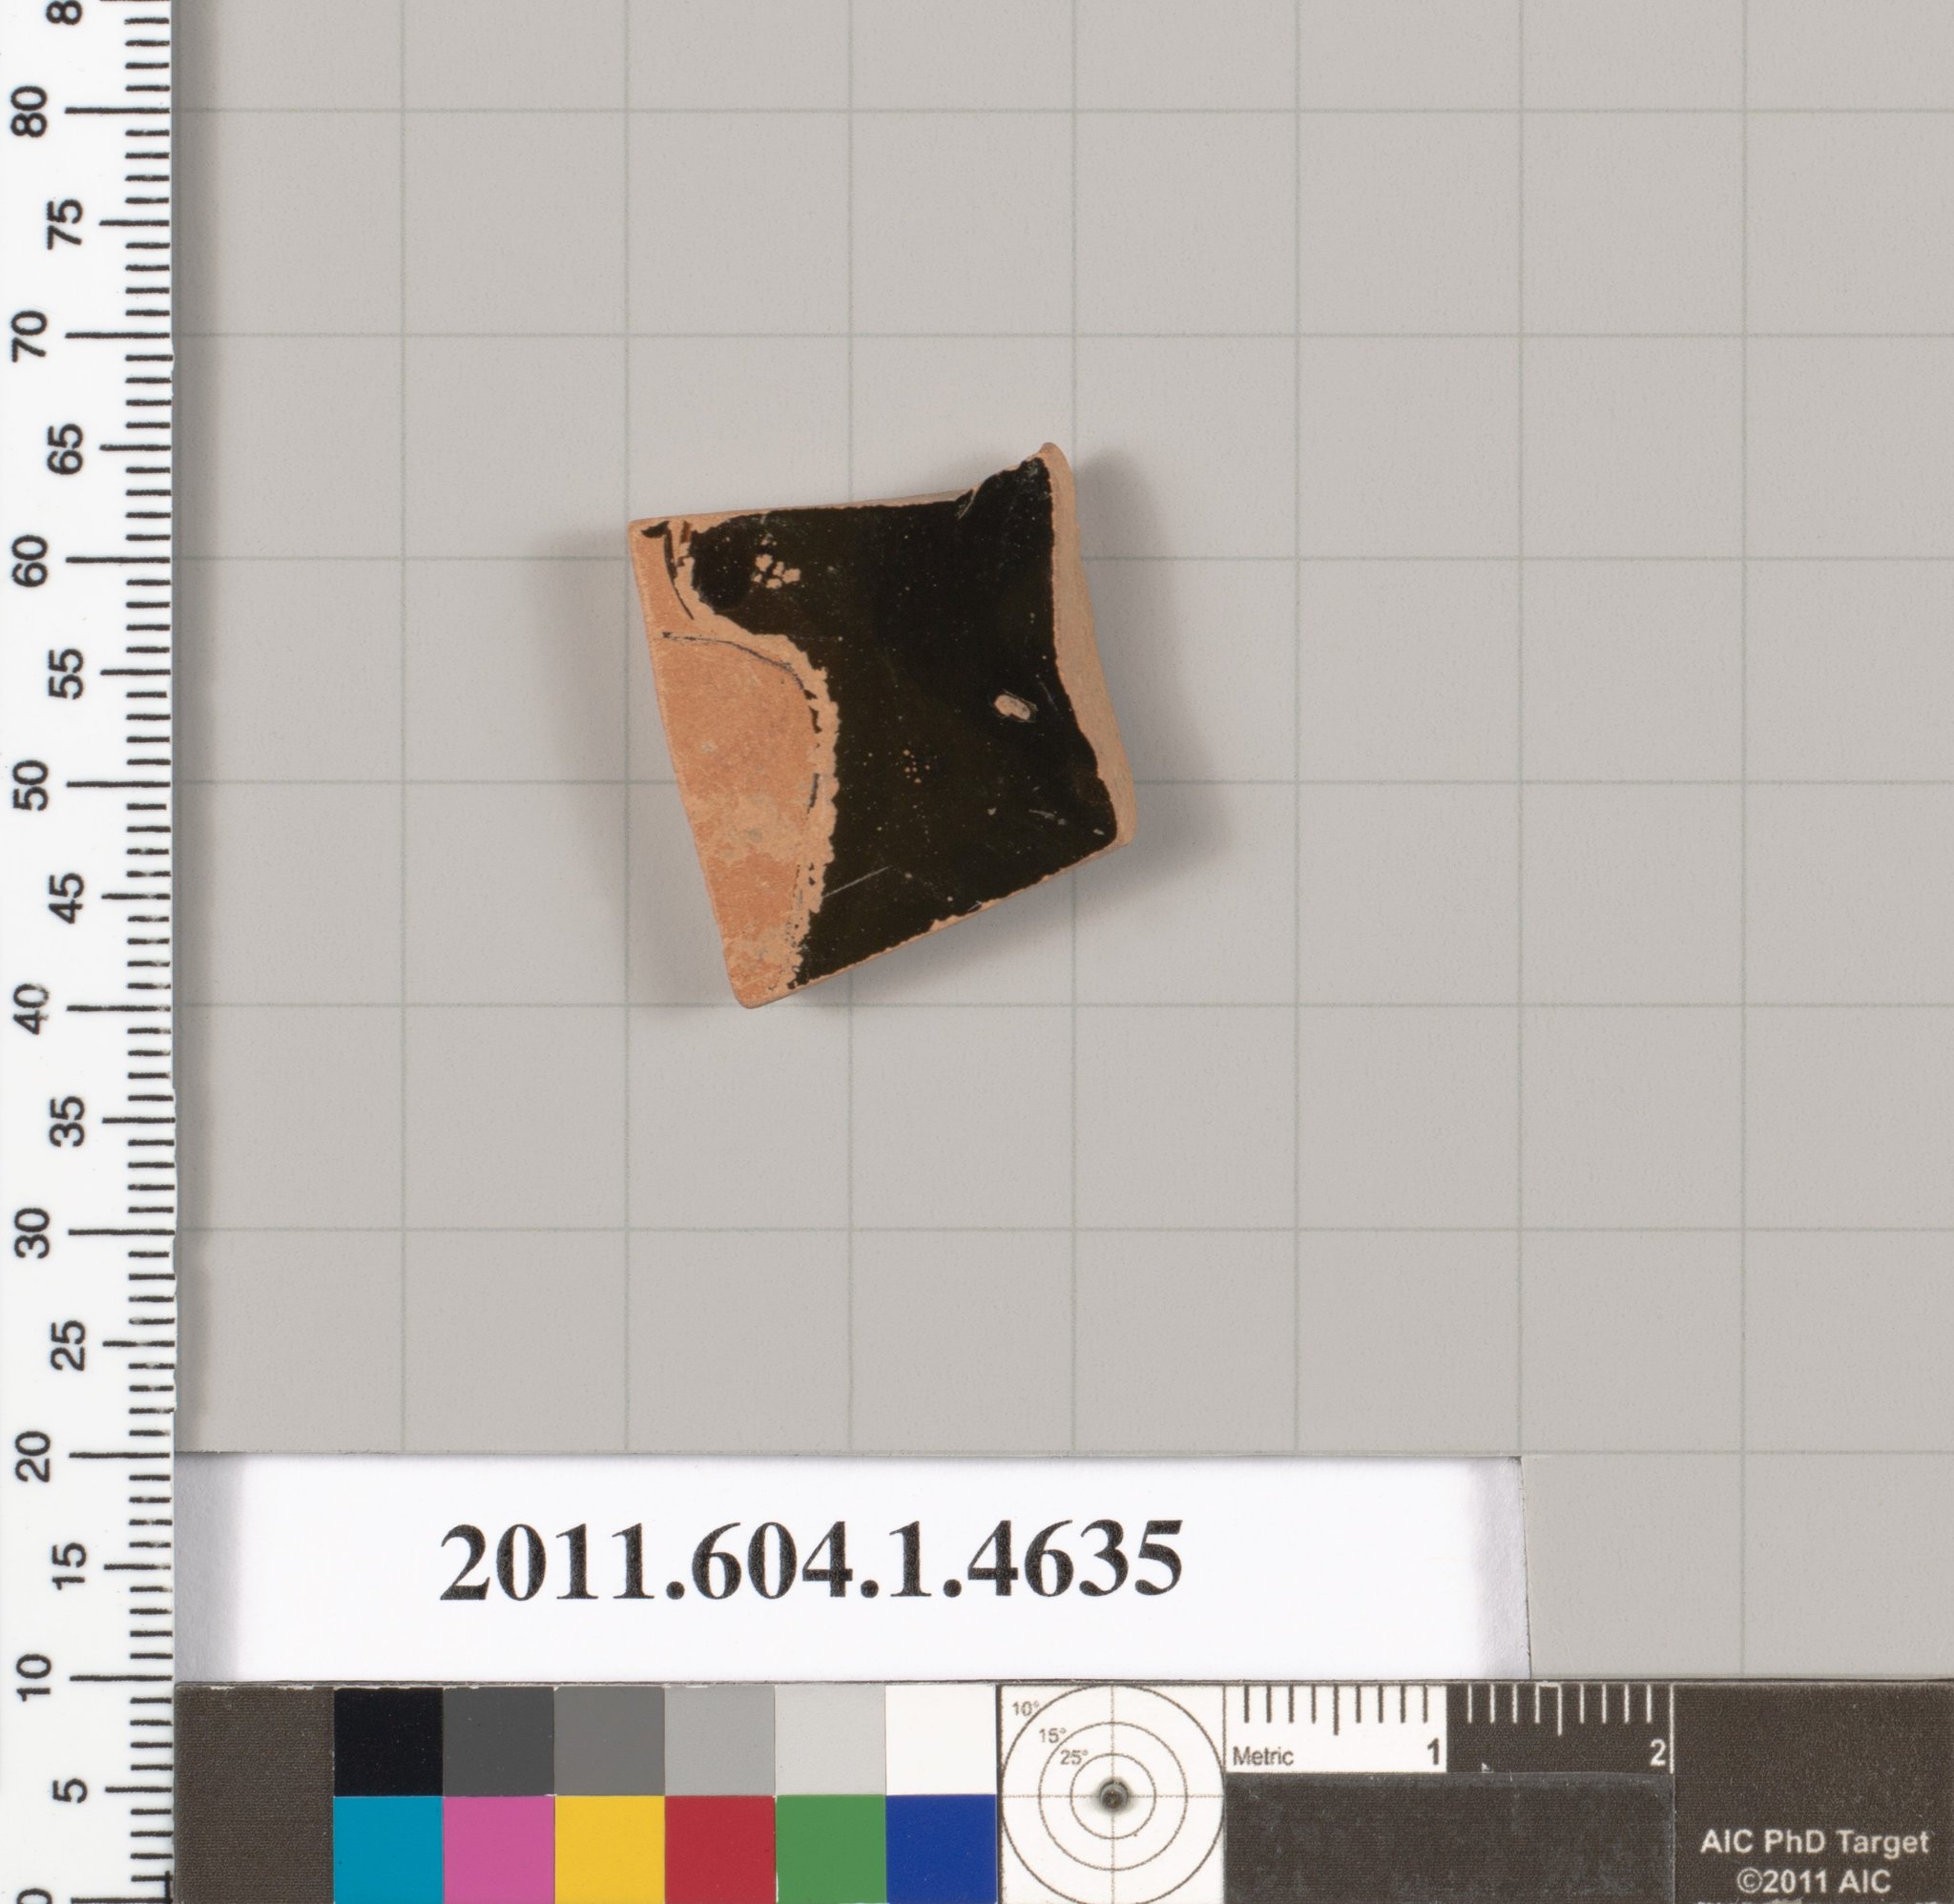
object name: kylix fragment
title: Terracotta fragment of a kylix (drinking cup)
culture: greek, attic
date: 475-451 BCE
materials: terracotta